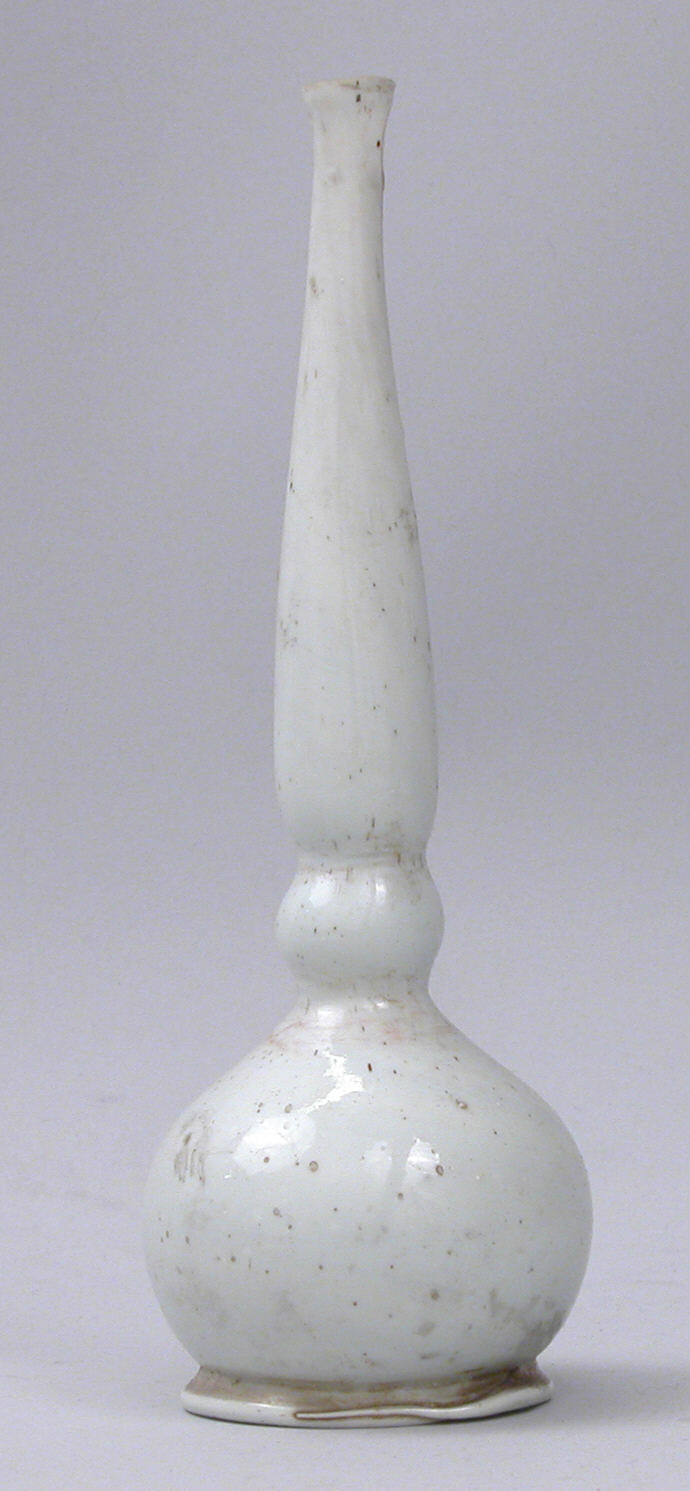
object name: bottle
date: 1701-1900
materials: glass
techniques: glassblowing, tooling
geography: iran